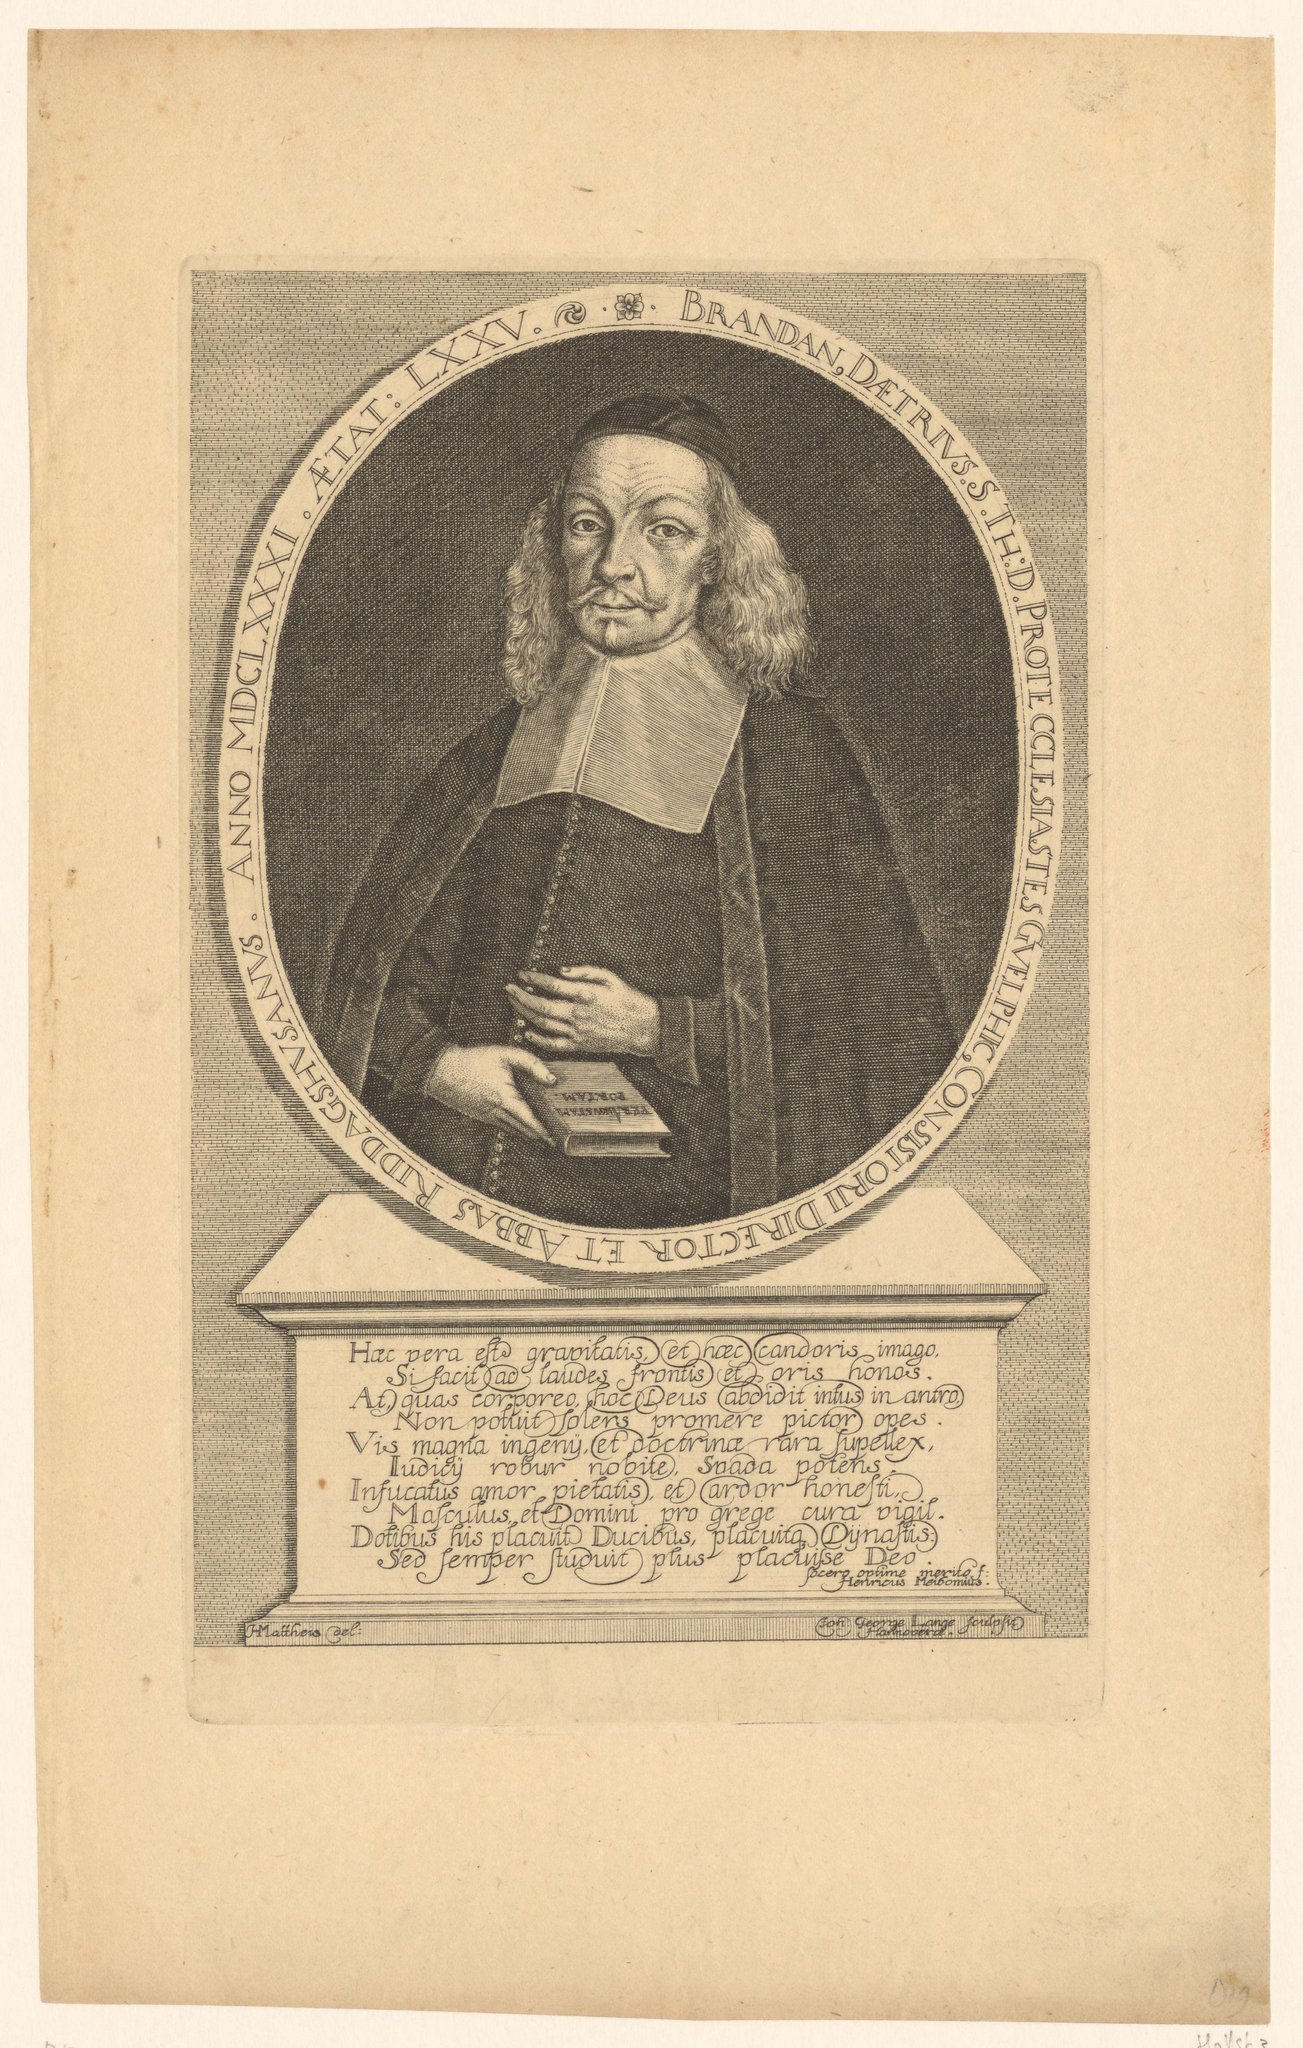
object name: print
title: Portret van Brandanus Daetrius op 75-jarige leeftijd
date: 1681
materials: paper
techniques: engraving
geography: hannover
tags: brandanus daetrius, theologian, historical persons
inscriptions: collector's mark: Lugt 2228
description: Tekst in het Latijn in de omlijsting en op de sokkel.